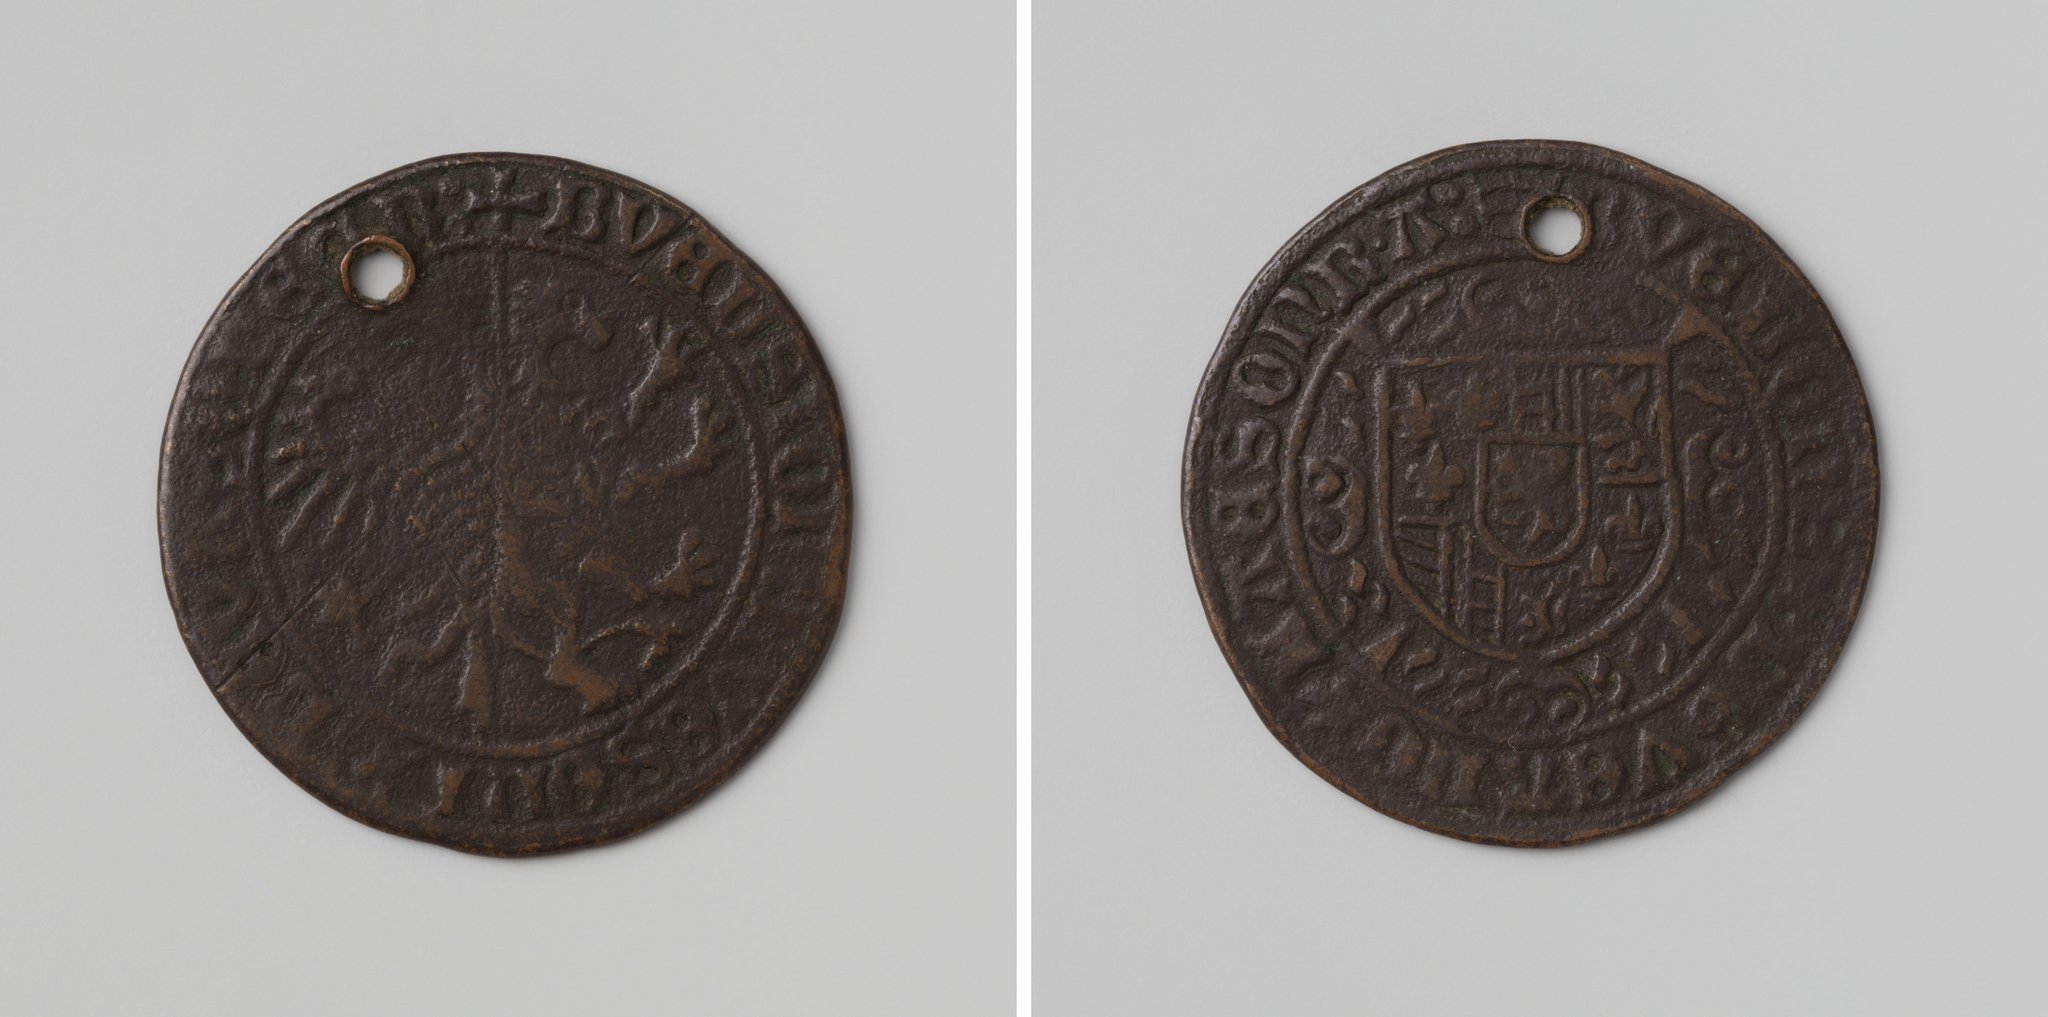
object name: jeton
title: Huwelijk van Maximiliaan, aartshertog van Oostenrijk met Maria, hertogin van Bourgondie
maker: Anonymous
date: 1477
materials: copper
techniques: striking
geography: brabant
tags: brussels, bruges, maria (hertogin van bourgondië), maximilian i (holy roman emperor)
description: Koperen penning met gat erin. Voorzijde: verticaal in tweeen gedeeld veld; links: Oostenrijkse adelaar, rechts: Bourgondische leeuw binnen omschrift. Keerzijde: wapenschild, omgeven door vier vuurslagen, waar vonken uitschieten binnen omschrift.